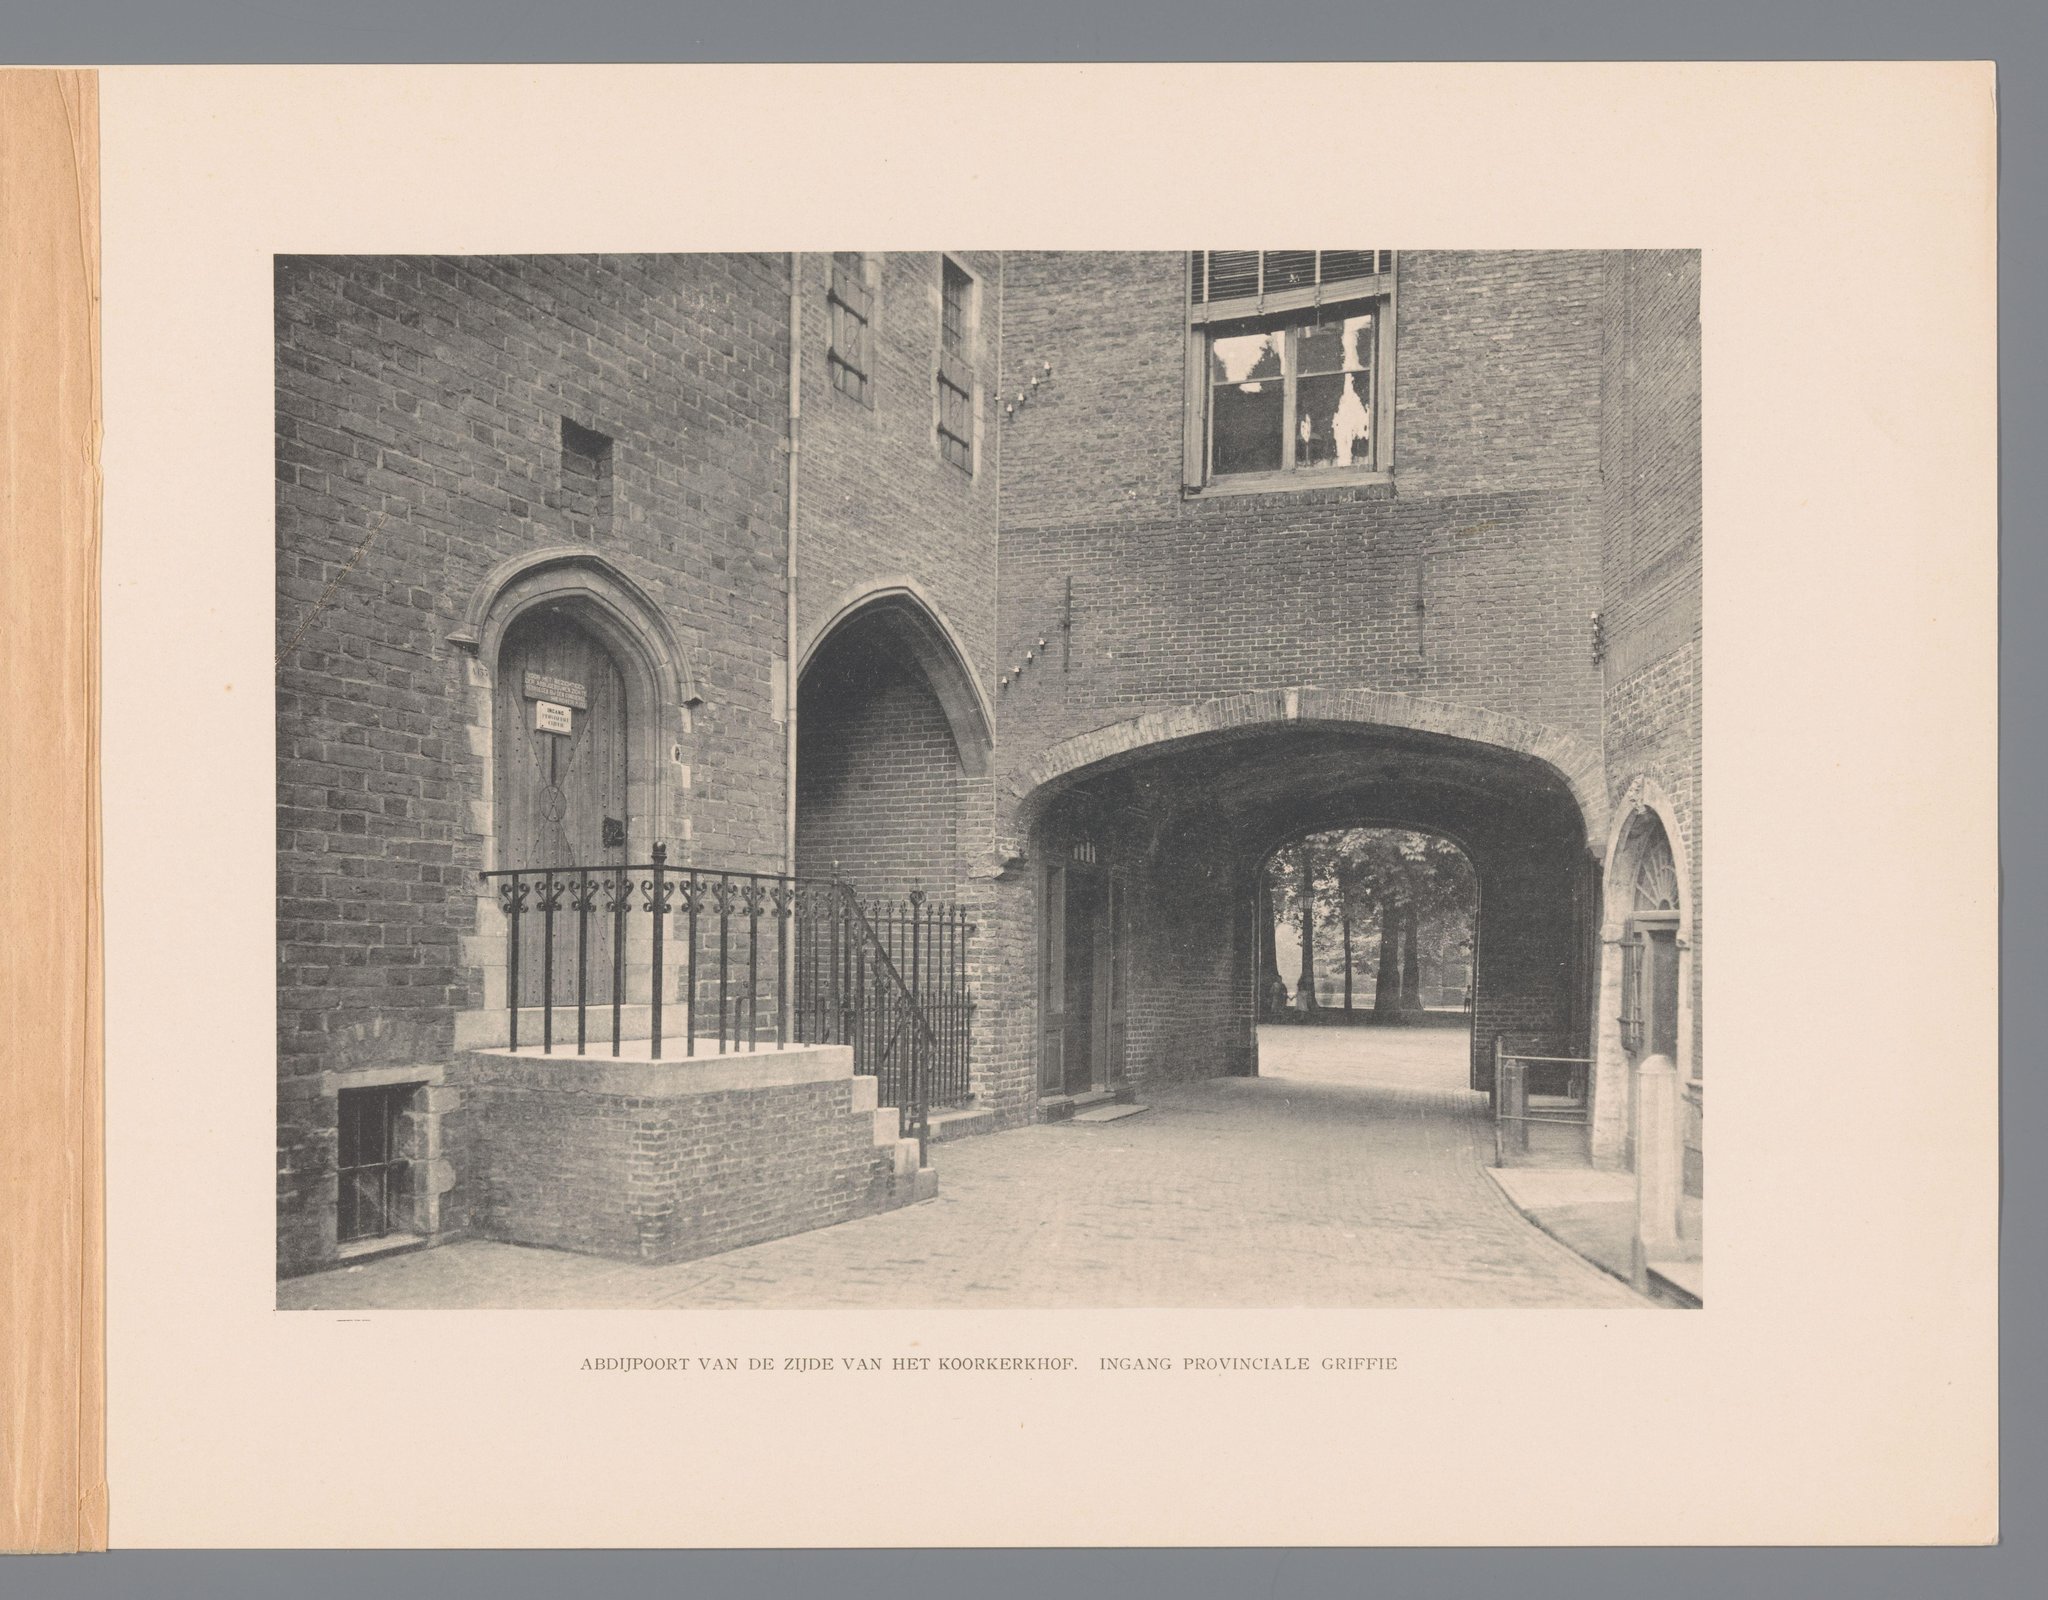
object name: photomechanical print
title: Abdijpoort van de zijde van het koorkerkhof, ingang provinciale griffie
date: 1900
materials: paper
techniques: photograph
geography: middelburg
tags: abbey, monastery, convent ~ roman catholic church, gate, entrance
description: Deze afdruk maakt deel uit van een omslag met acht lichtdrukken.